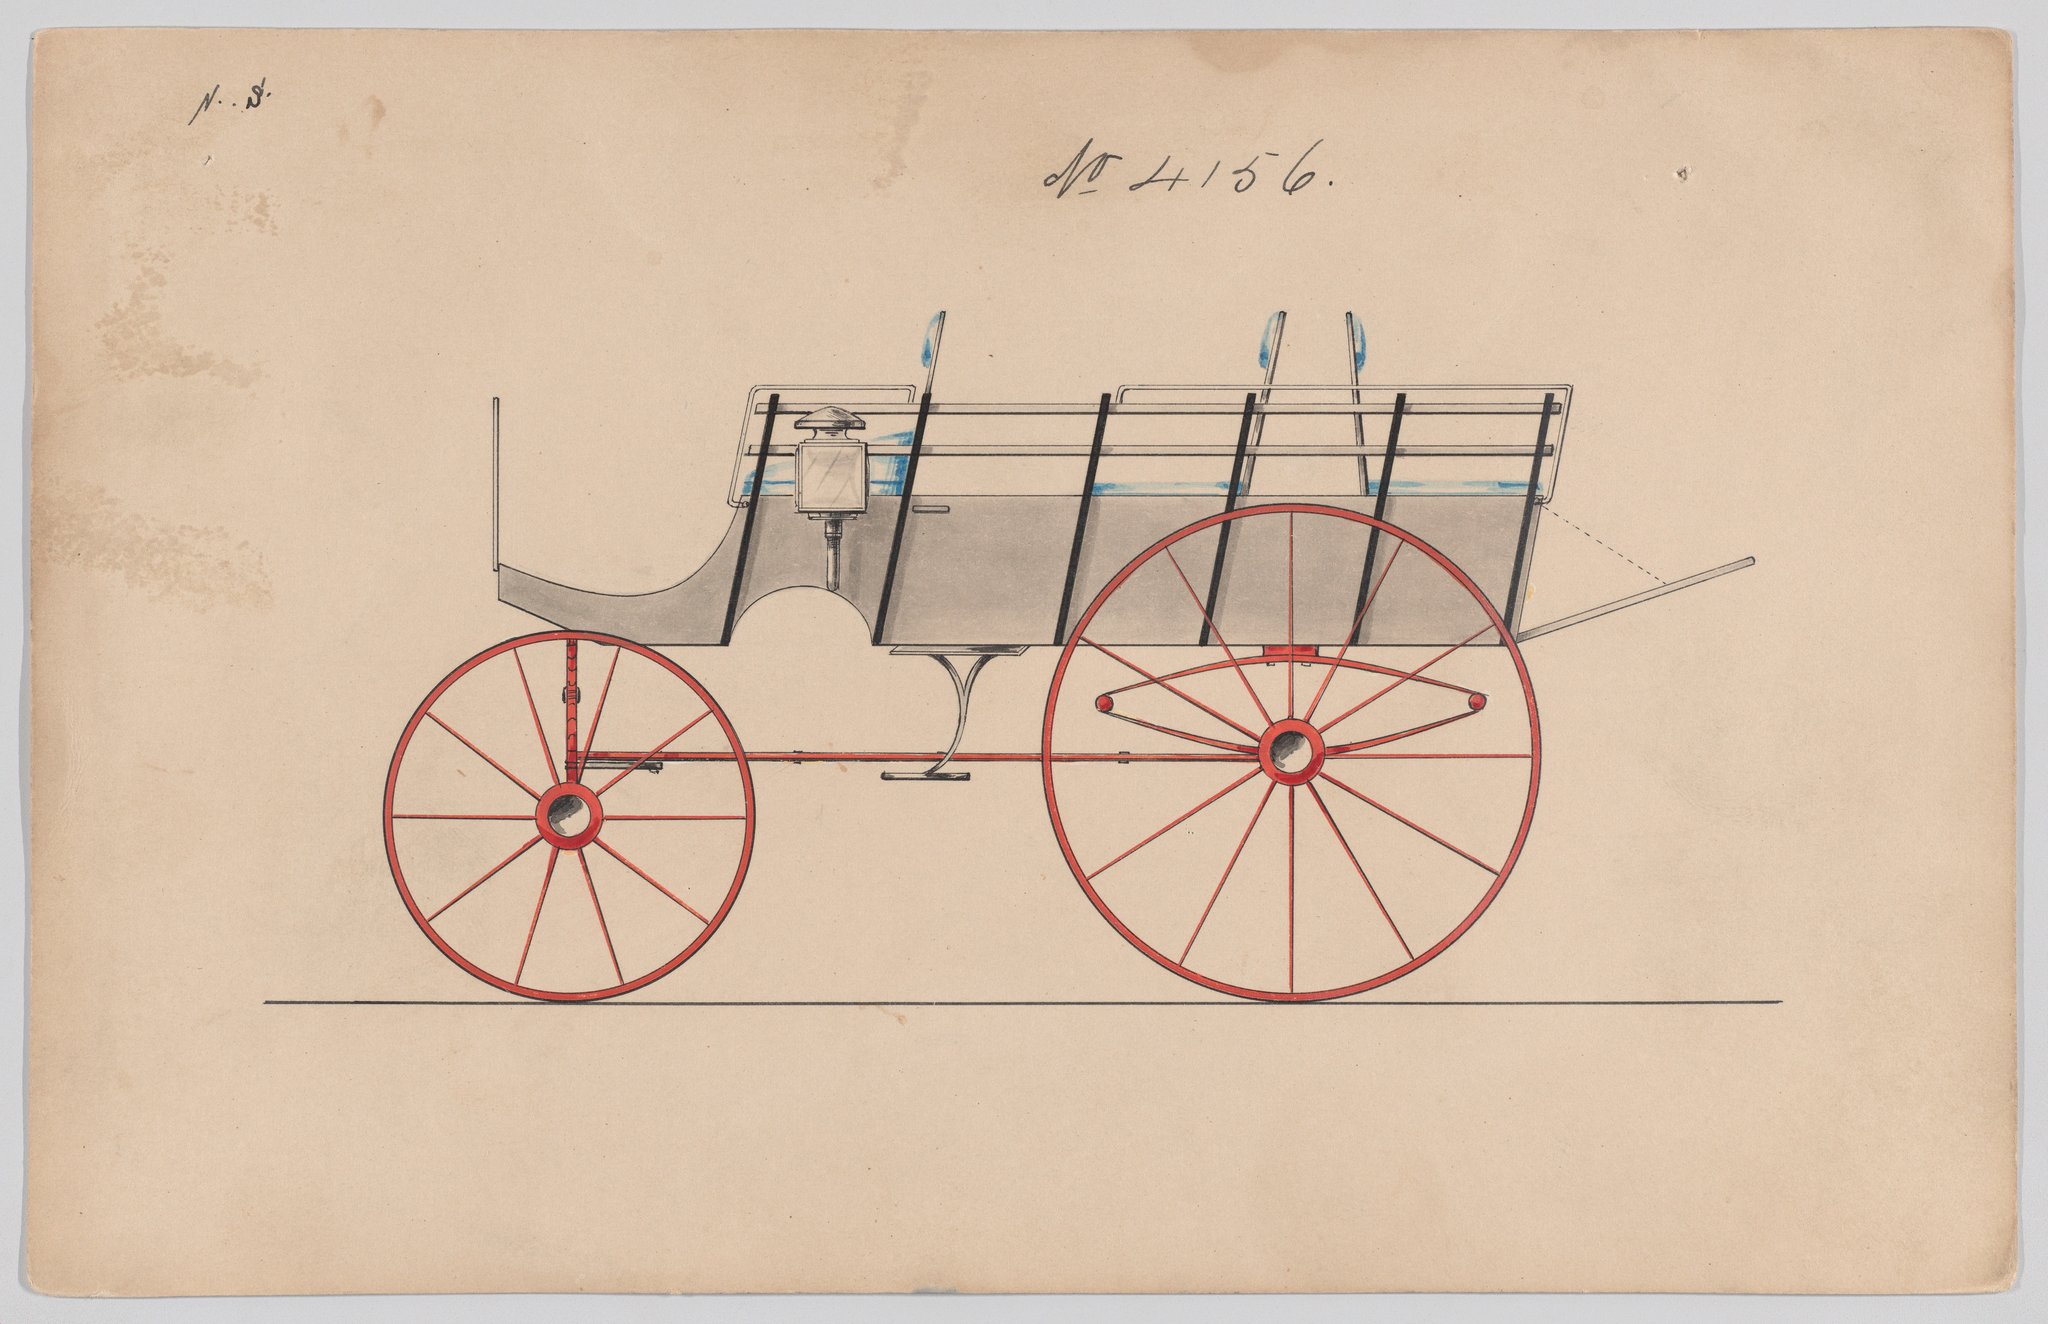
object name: drawing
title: Slat Side Phaeton #4156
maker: brewster & co.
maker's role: manufacturer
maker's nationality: american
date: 1892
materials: gouache, ink, watercolor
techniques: pen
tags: carriages